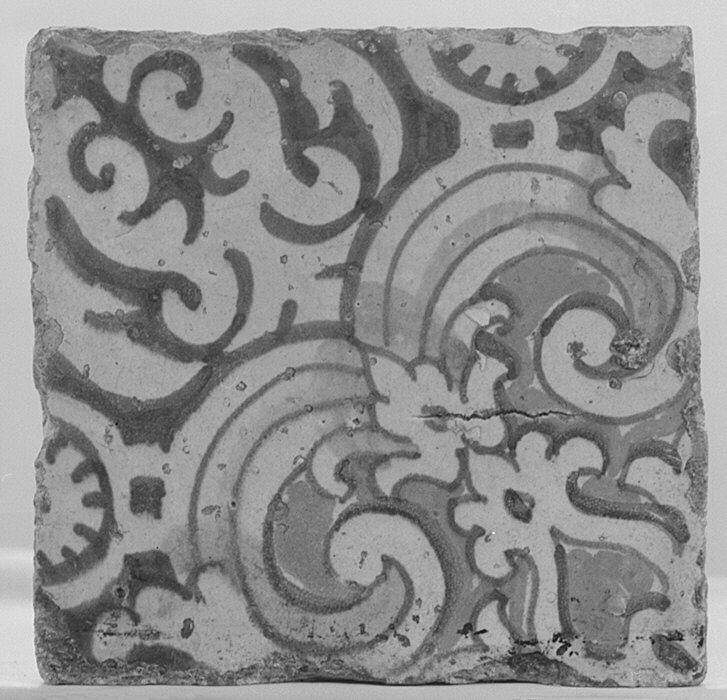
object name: floor tile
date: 1580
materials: earthenware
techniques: glazing